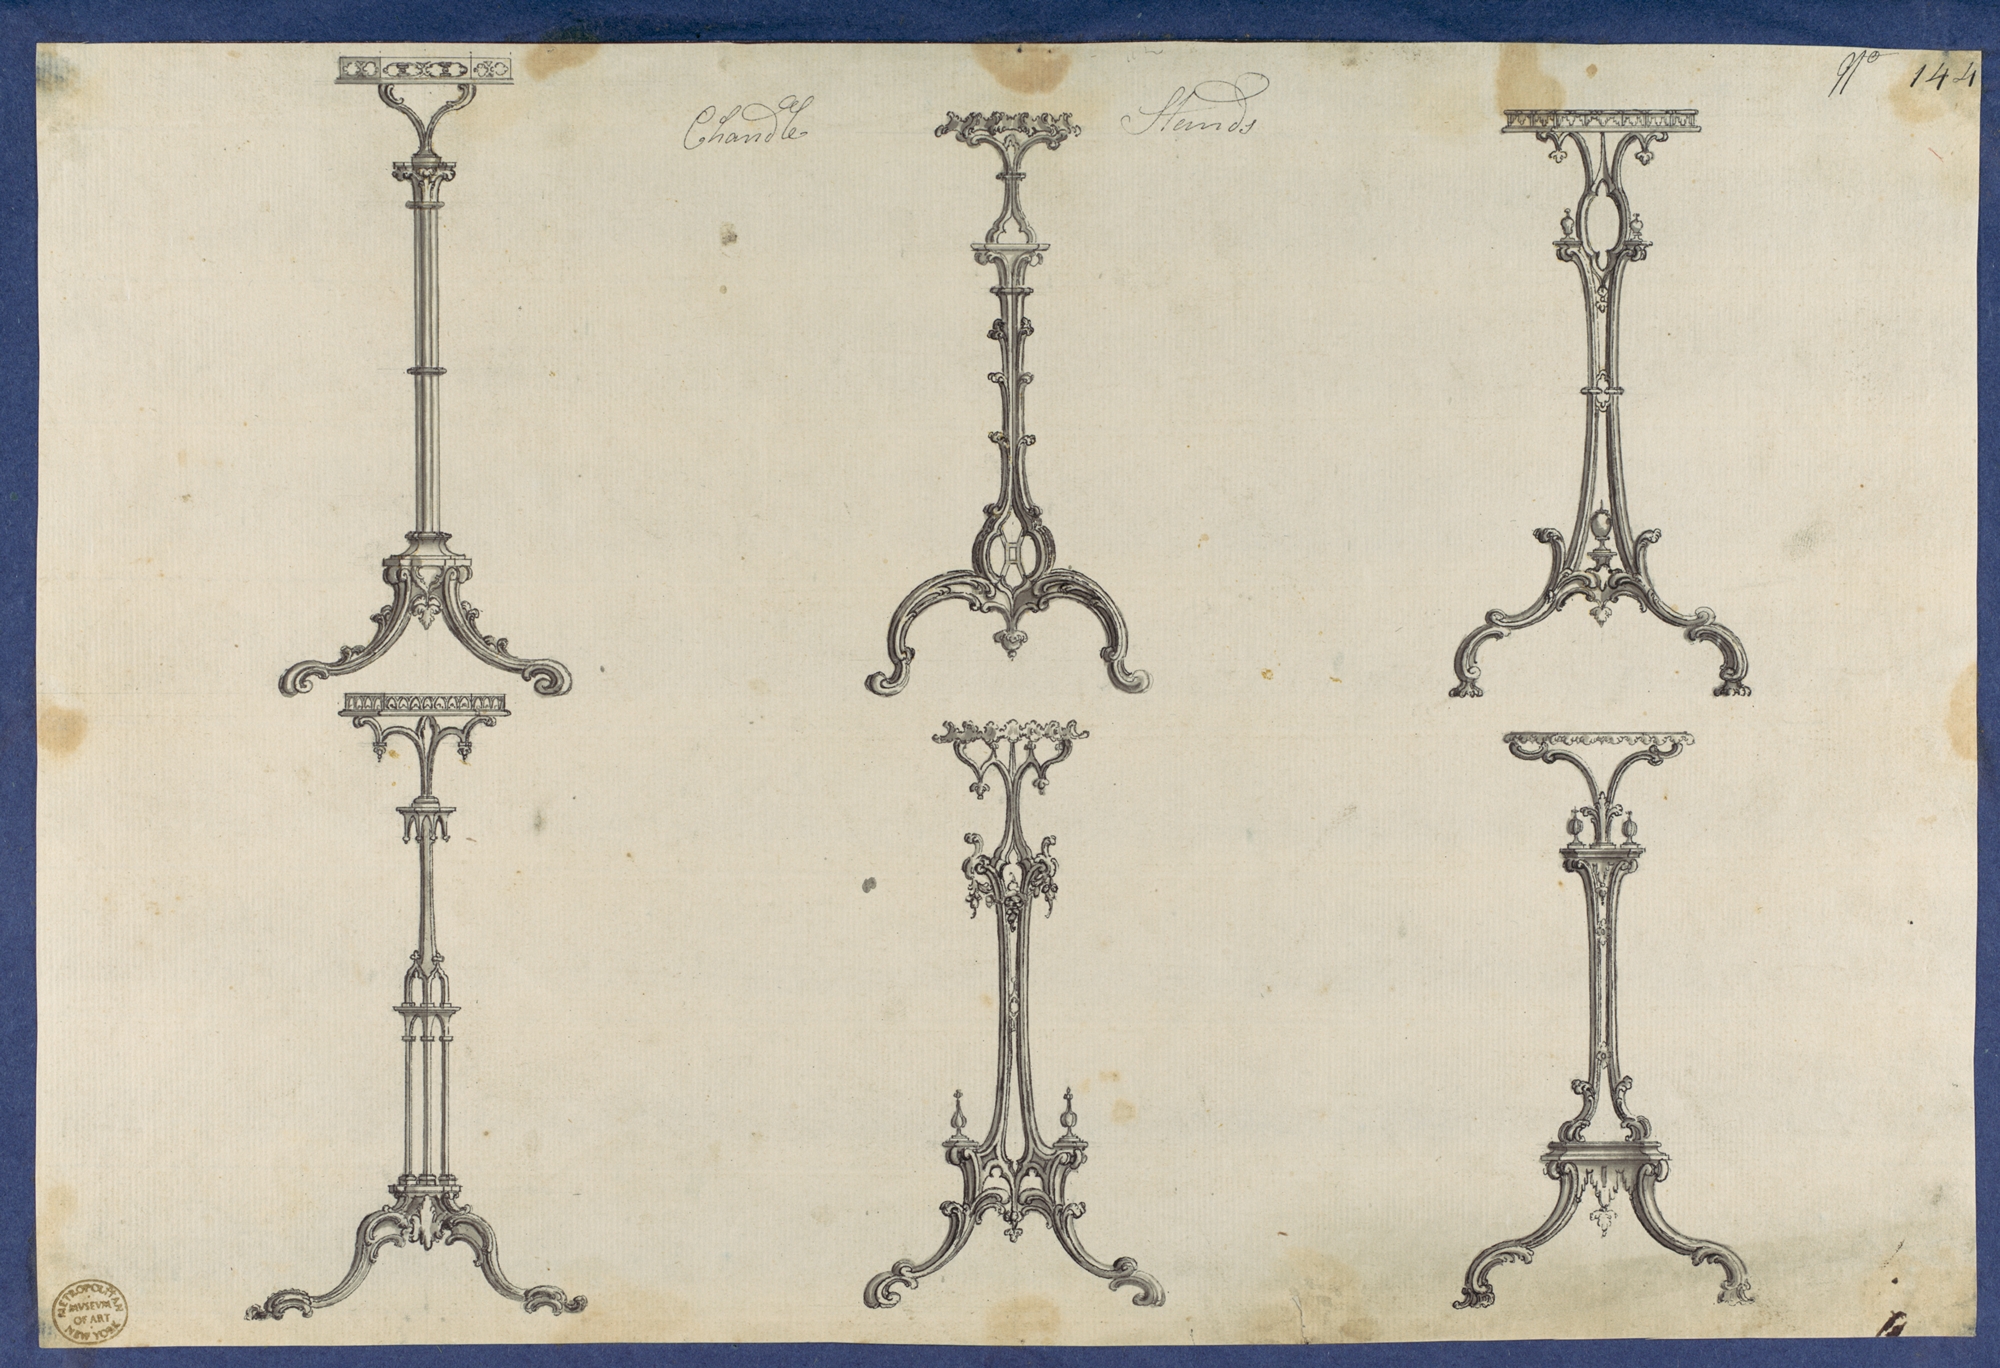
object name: drawing ornament architecture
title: Candle Stands, in Chippendale Drawings, Vol. I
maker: thomas chippendale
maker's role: artist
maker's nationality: british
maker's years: 1718-1779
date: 1760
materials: ink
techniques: wash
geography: london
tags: furniture